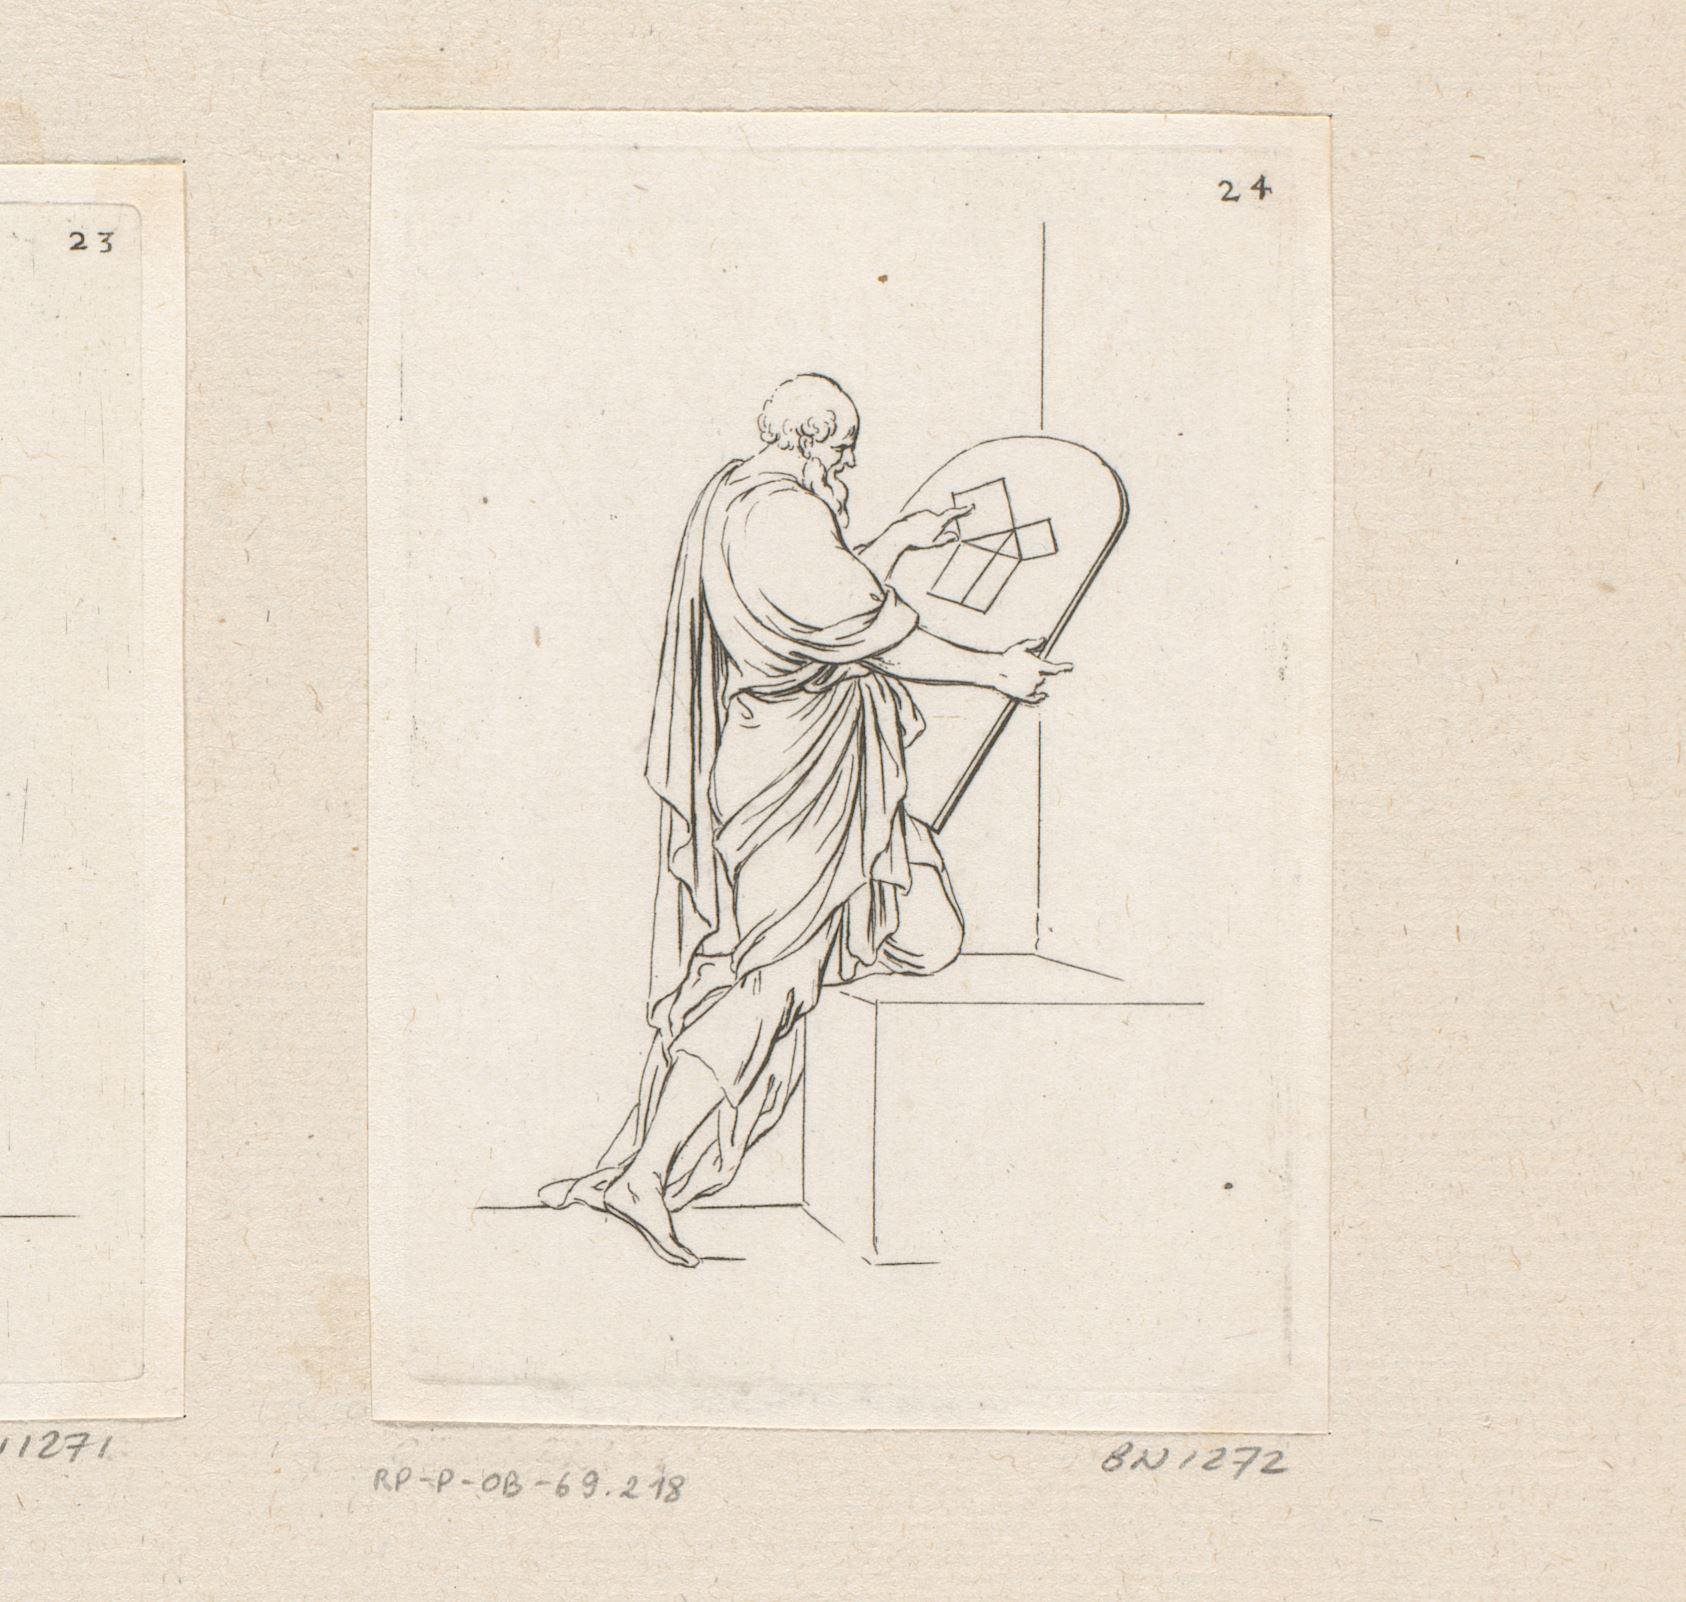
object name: print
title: Pythagoras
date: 1706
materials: paper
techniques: etching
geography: paris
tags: historical persons